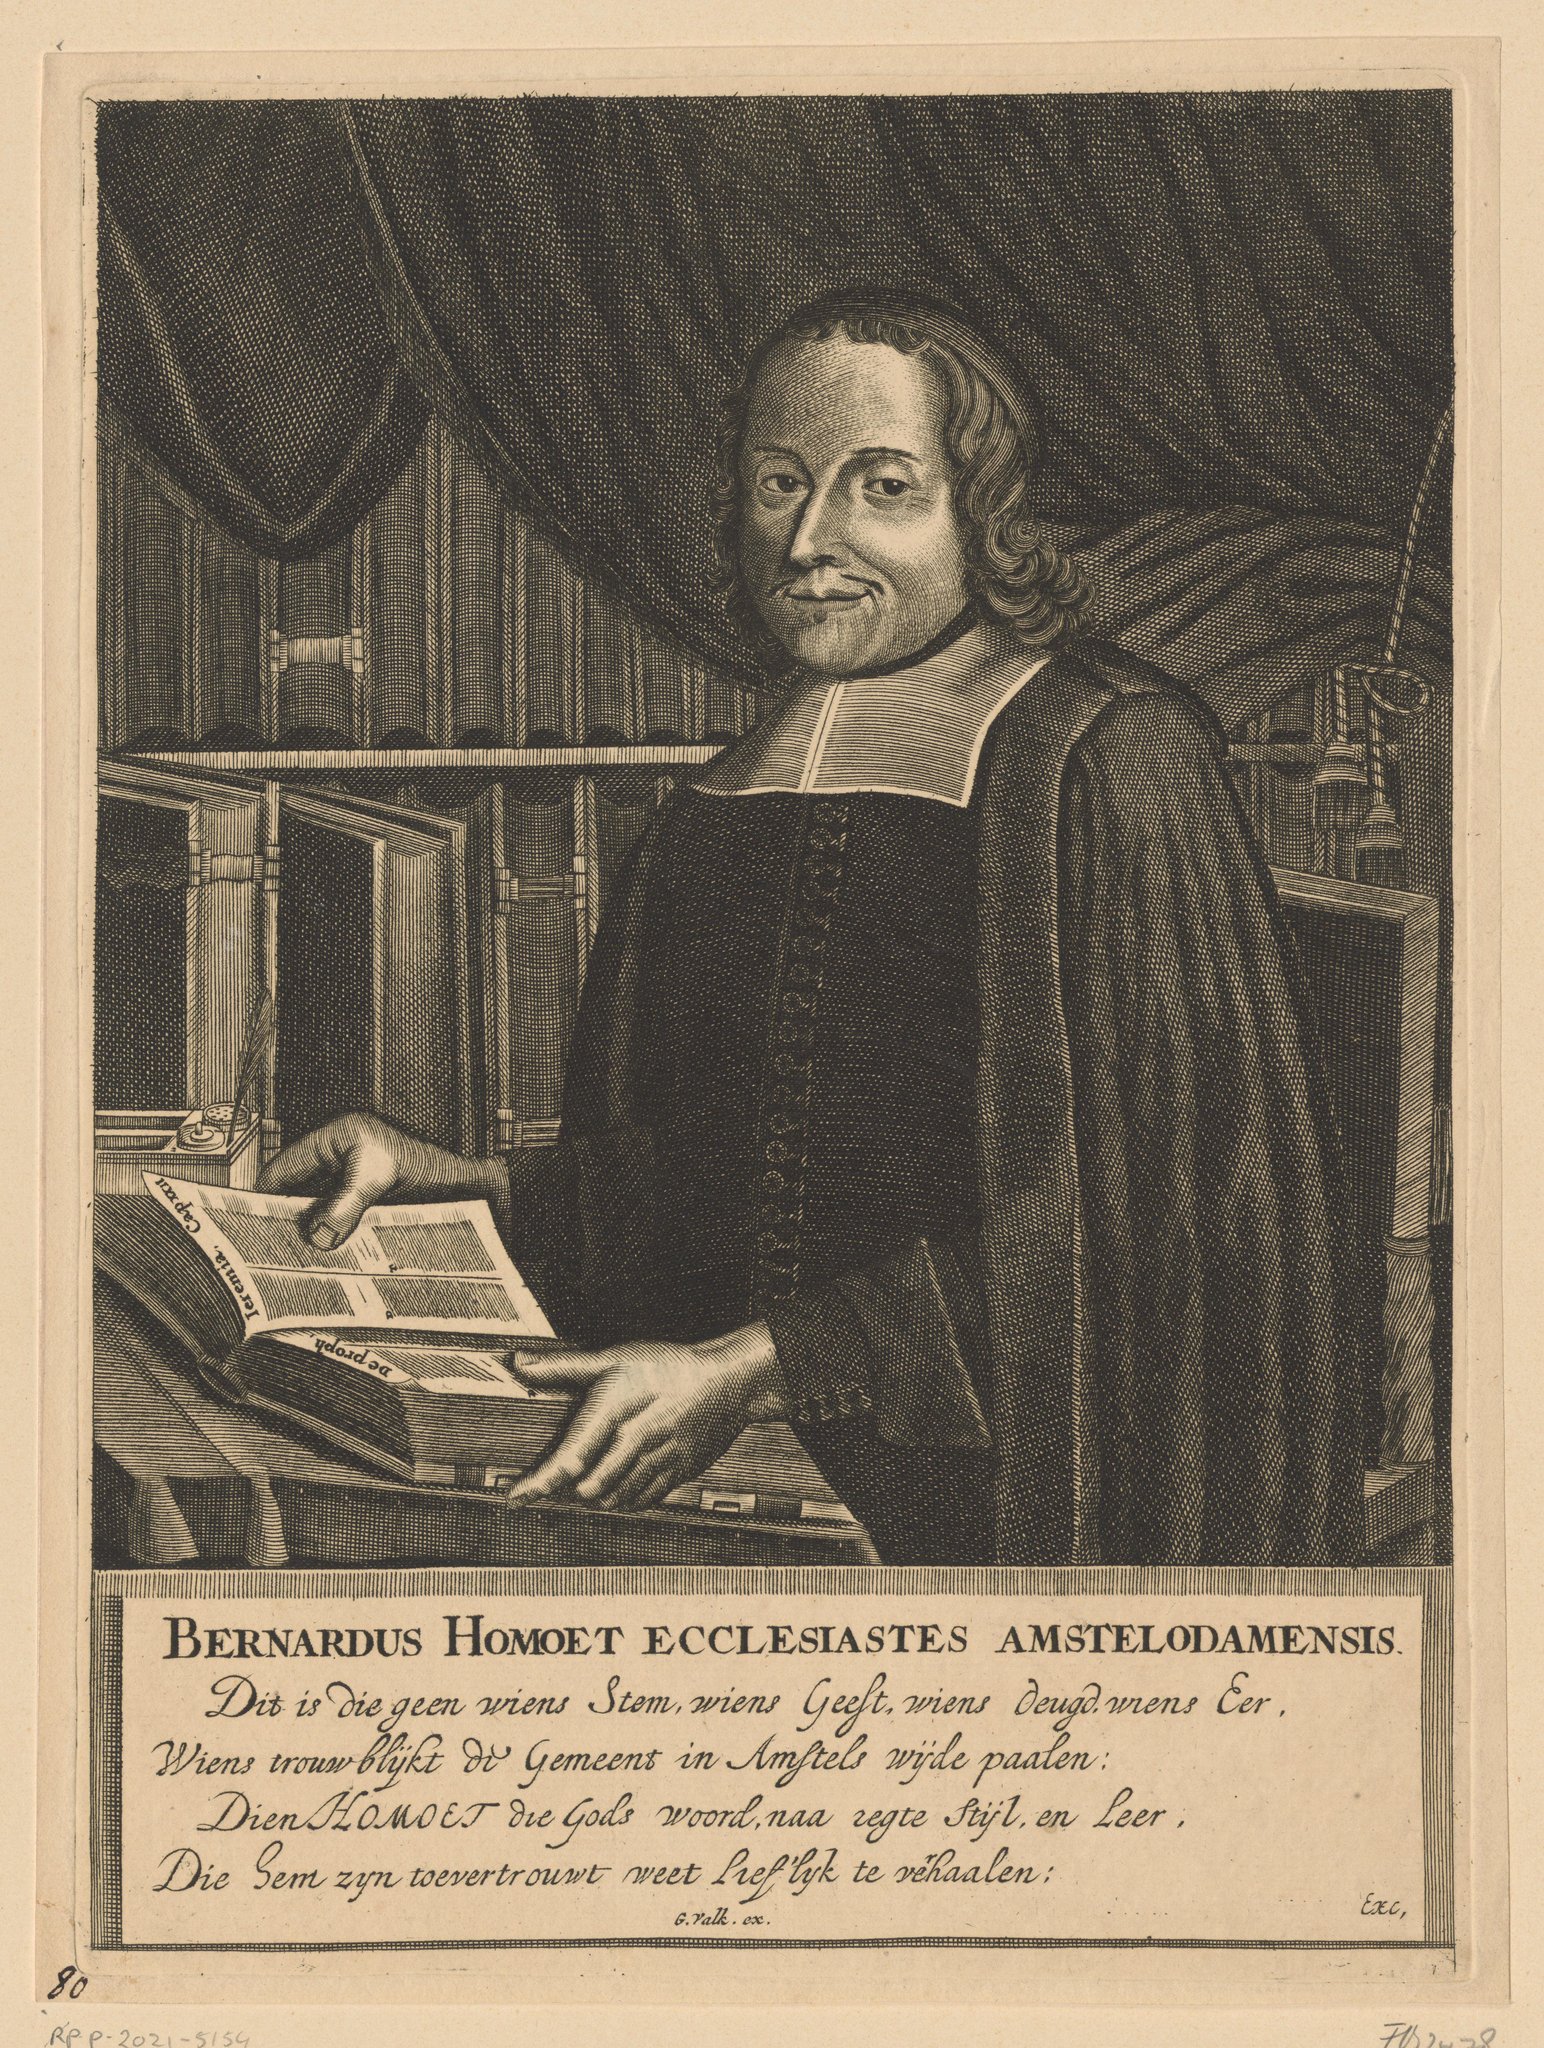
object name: print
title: Portret van Bernardus Homoet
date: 1670-1726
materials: paper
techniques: engraving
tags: amsterdam, adult man, historical persons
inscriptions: inscription: ‘80’